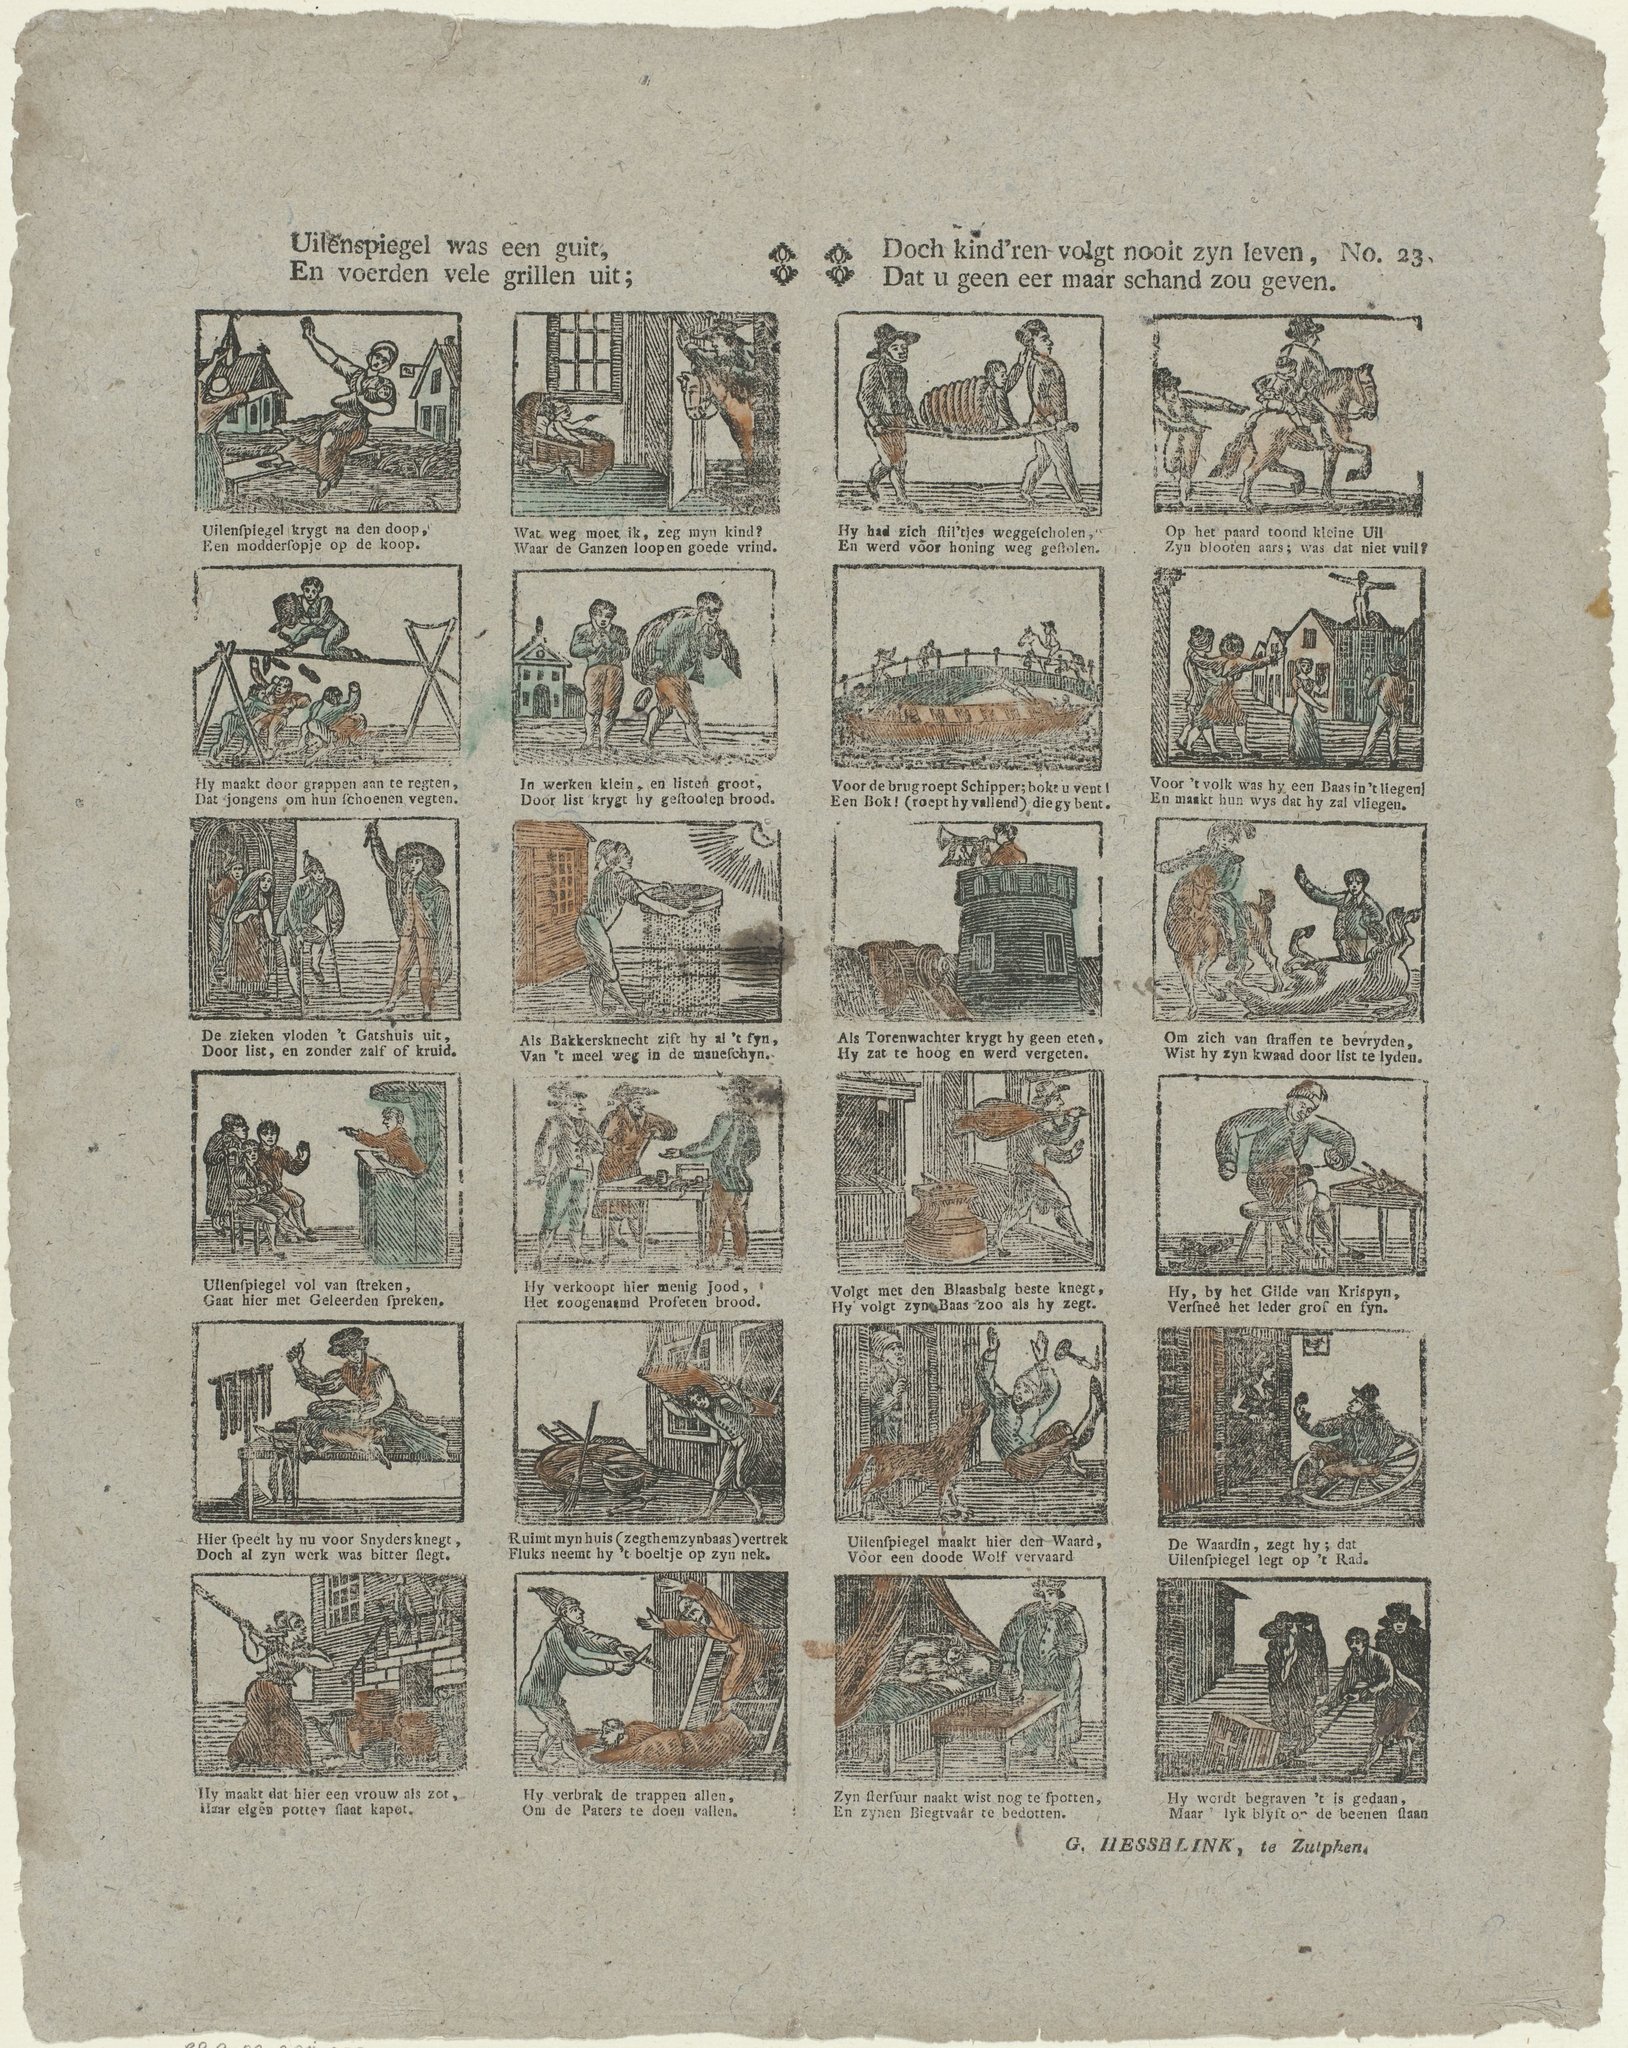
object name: popular print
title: Uilenspiegel was een guit, / En voerden vele grillen uit; / Doch kind'ren volgt nooit zyn leven, / Dat u geen eer maar schand zou geven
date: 1820-1838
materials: paper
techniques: colour, letterpress printing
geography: zutphen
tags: eulenspiegel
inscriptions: collector's mark: Lugt 2760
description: Blad met 24 voorstellingen over het leven van Tijl Uilenspiegel. Onder elke afbeelding een tweeregelig vers. Genummerd rechtsboven: No. 23.